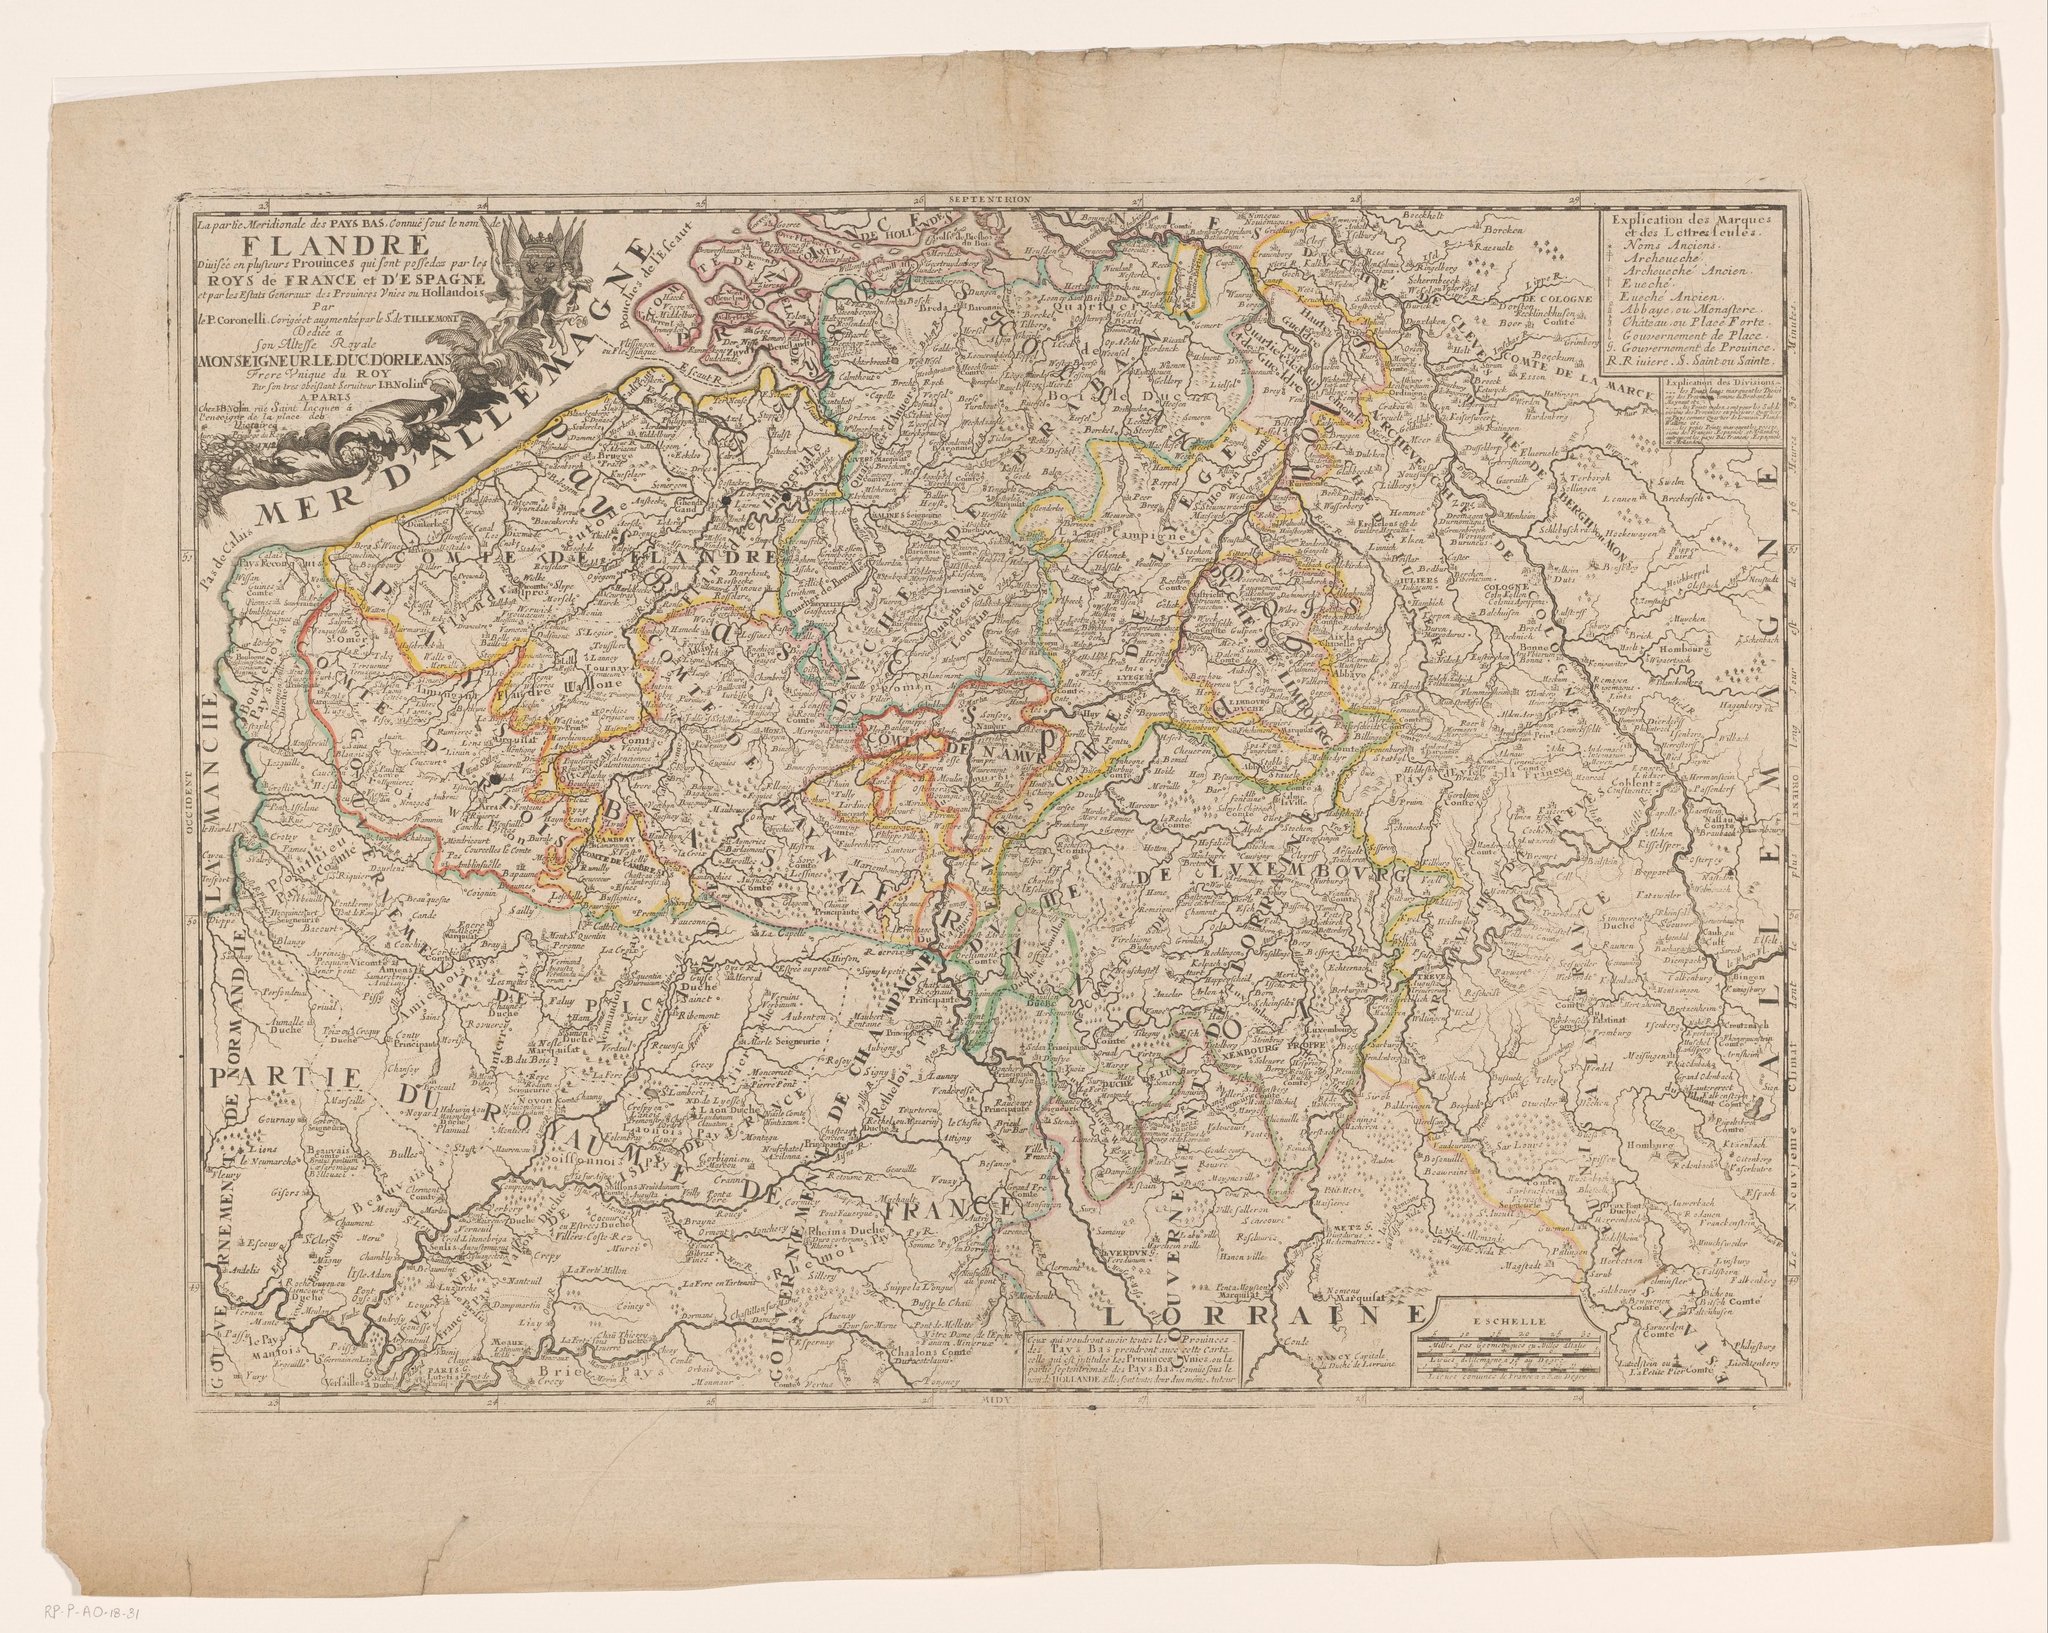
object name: map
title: Kaart van Vlaanderen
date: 1742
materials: paper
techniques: engraving, etching, hand coloring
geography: paris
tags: maps of separate countries or regions, armorial bearing, heraldry, belgium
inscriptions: date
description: Kaart van Vlaanderen. Linksboven een cartouche met titel, opdracht en het wapen van de koning van Frankrijk. Rechtsboven twee kaders met legenda. Onder, rechts van het midden een kader met tekst en een kader met drie schaalstokken: 30 Milles pas Geometriques ou Milles d'Italie / 7 1/2 Lieües d'Allemagne a 10 au Degre / 12 Lieües comunes de France a 20 au Degre. De kaart is voorzien van een gradenverdeling langs de randen.